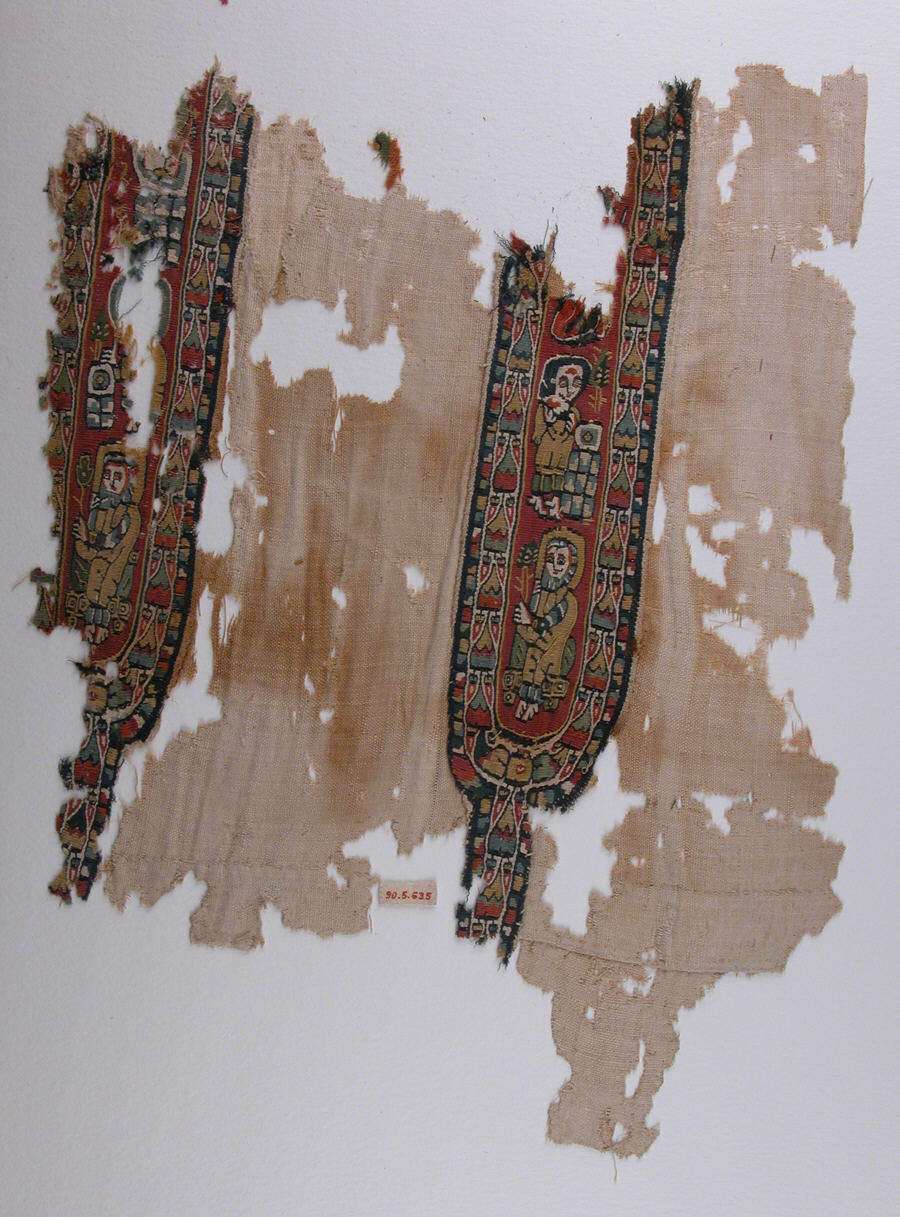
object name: textile fragment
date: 501-700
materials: linen, wool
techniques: weave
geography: egypt